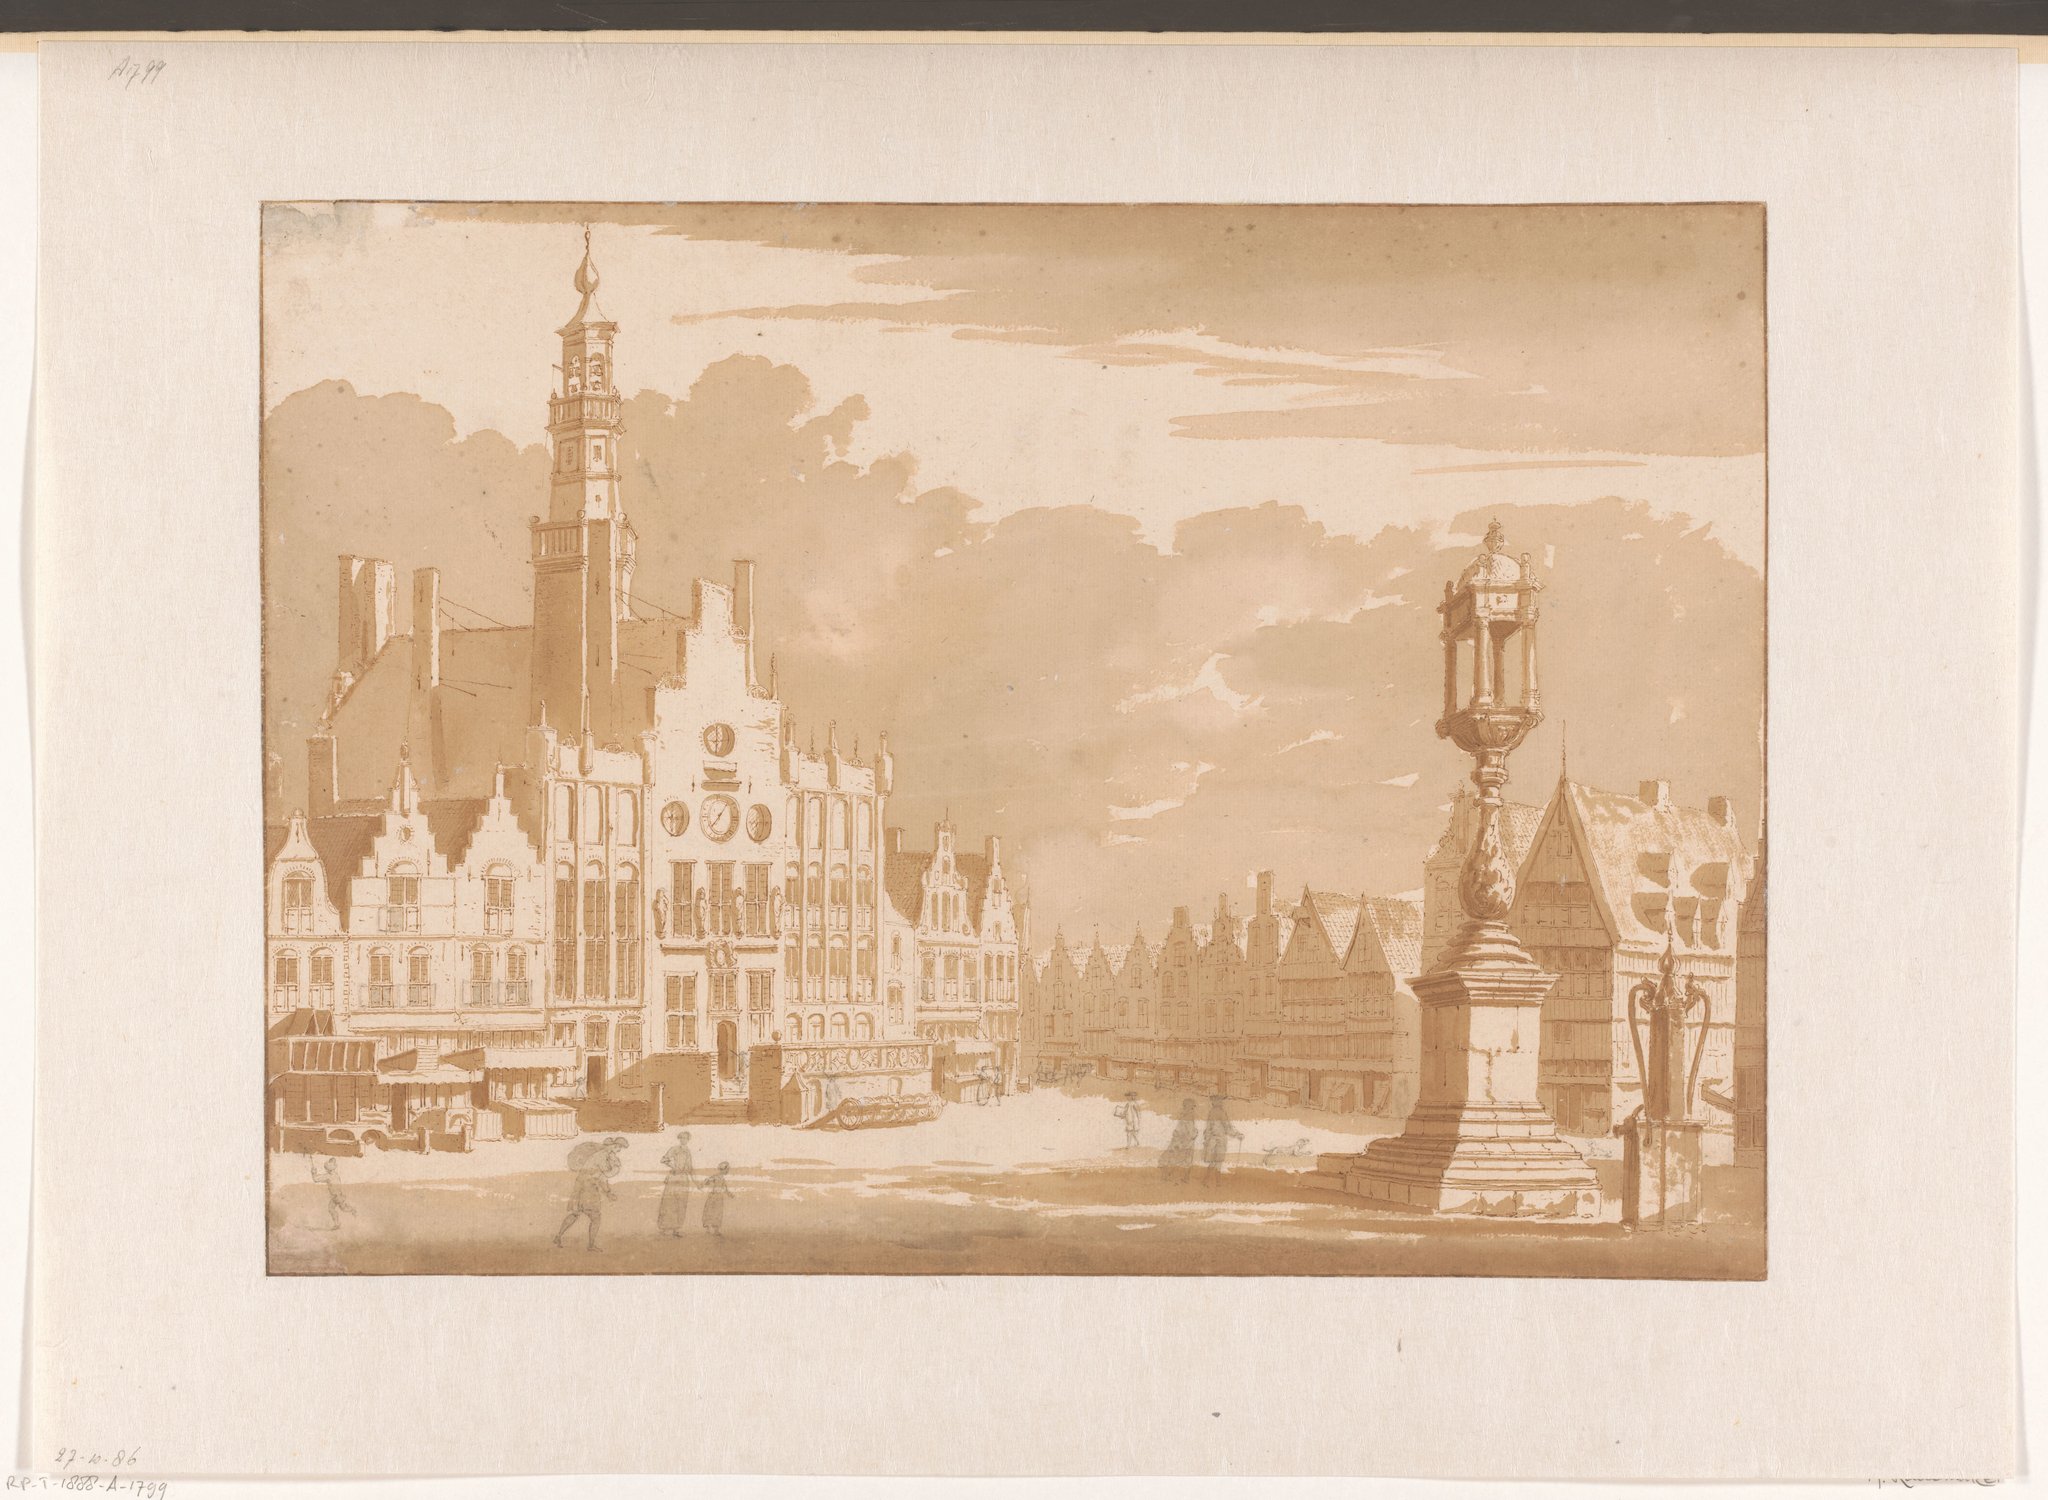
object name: drawing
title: Gezicht op de markt en stadhuis te 's-Hertogenbosch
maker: abraham rademaker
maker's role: draughtsman, print maker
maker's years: 1676-1735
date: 1685-1735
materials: ink, paper, pencil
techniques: brush, pen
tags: square, place, circus, etc., townhall, den bosch